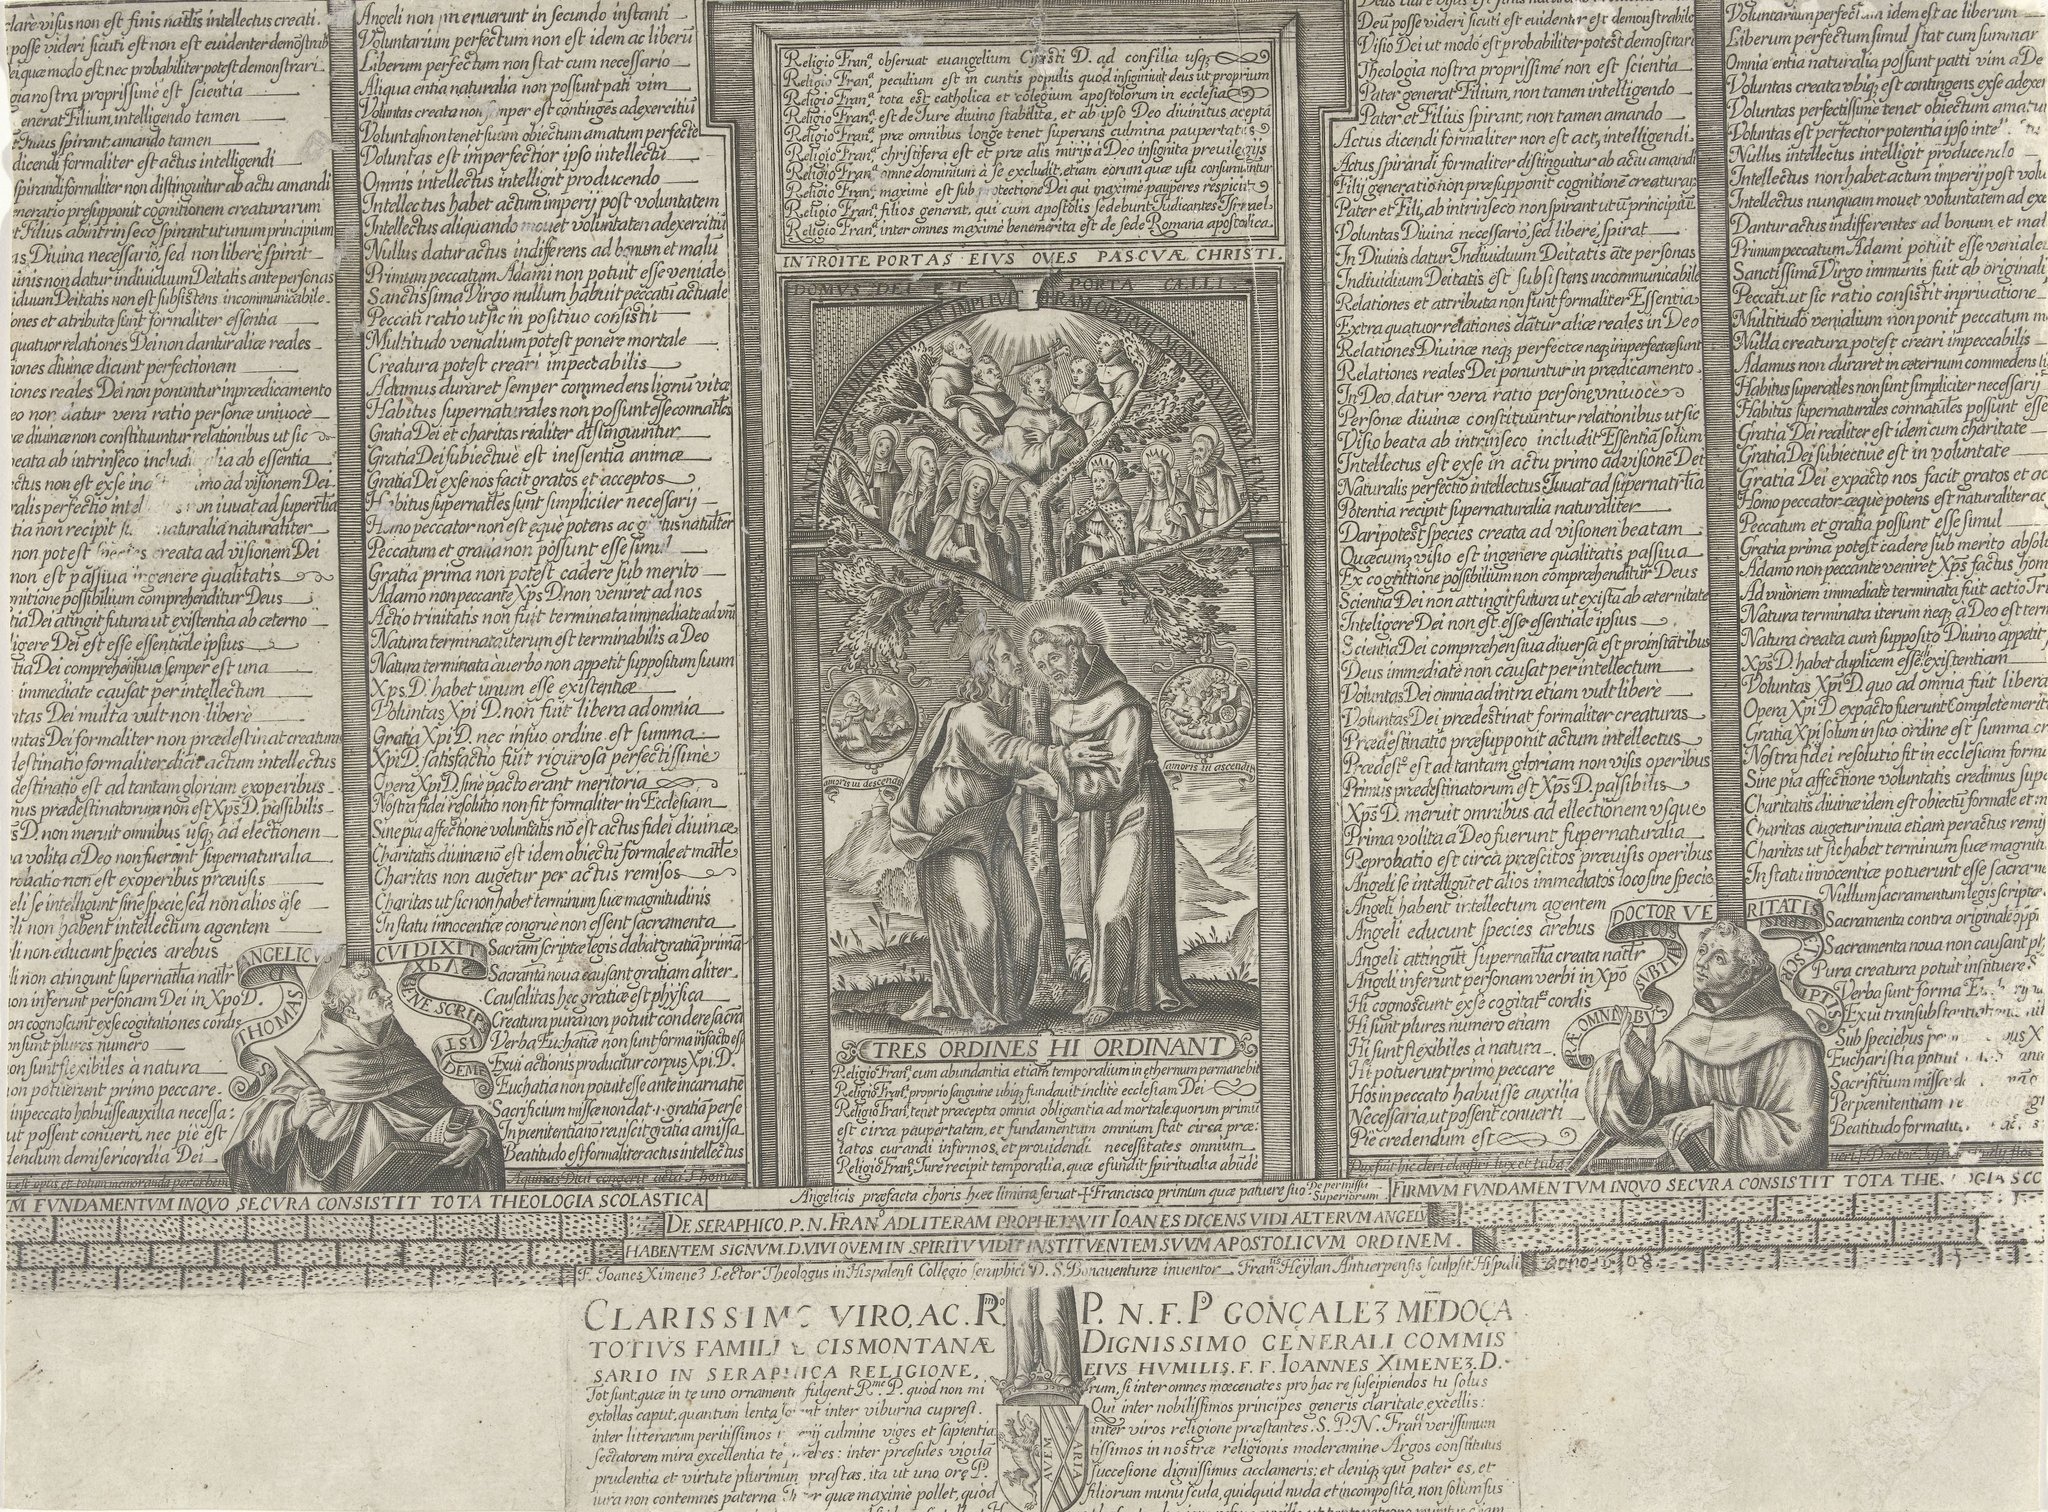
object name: print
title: Christus en de heilige Franciscus bij een boom met heiligen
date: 1608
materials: paper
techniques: engraving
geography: spain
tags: adult christ together with apostles, evangelists, saints, etc., founder of the order of friars minor (franciscans), francis(cus) of assisi; possible attributes: book, crucifix, lily, skull, stigmata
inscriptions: collector's mark: Lugt 2228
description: Christus en de heilige Franciscus bij een boom met daarin de beeltenissen van verschillende heiligen. De voorstelling is omgeven door een tekst in het Latijn.